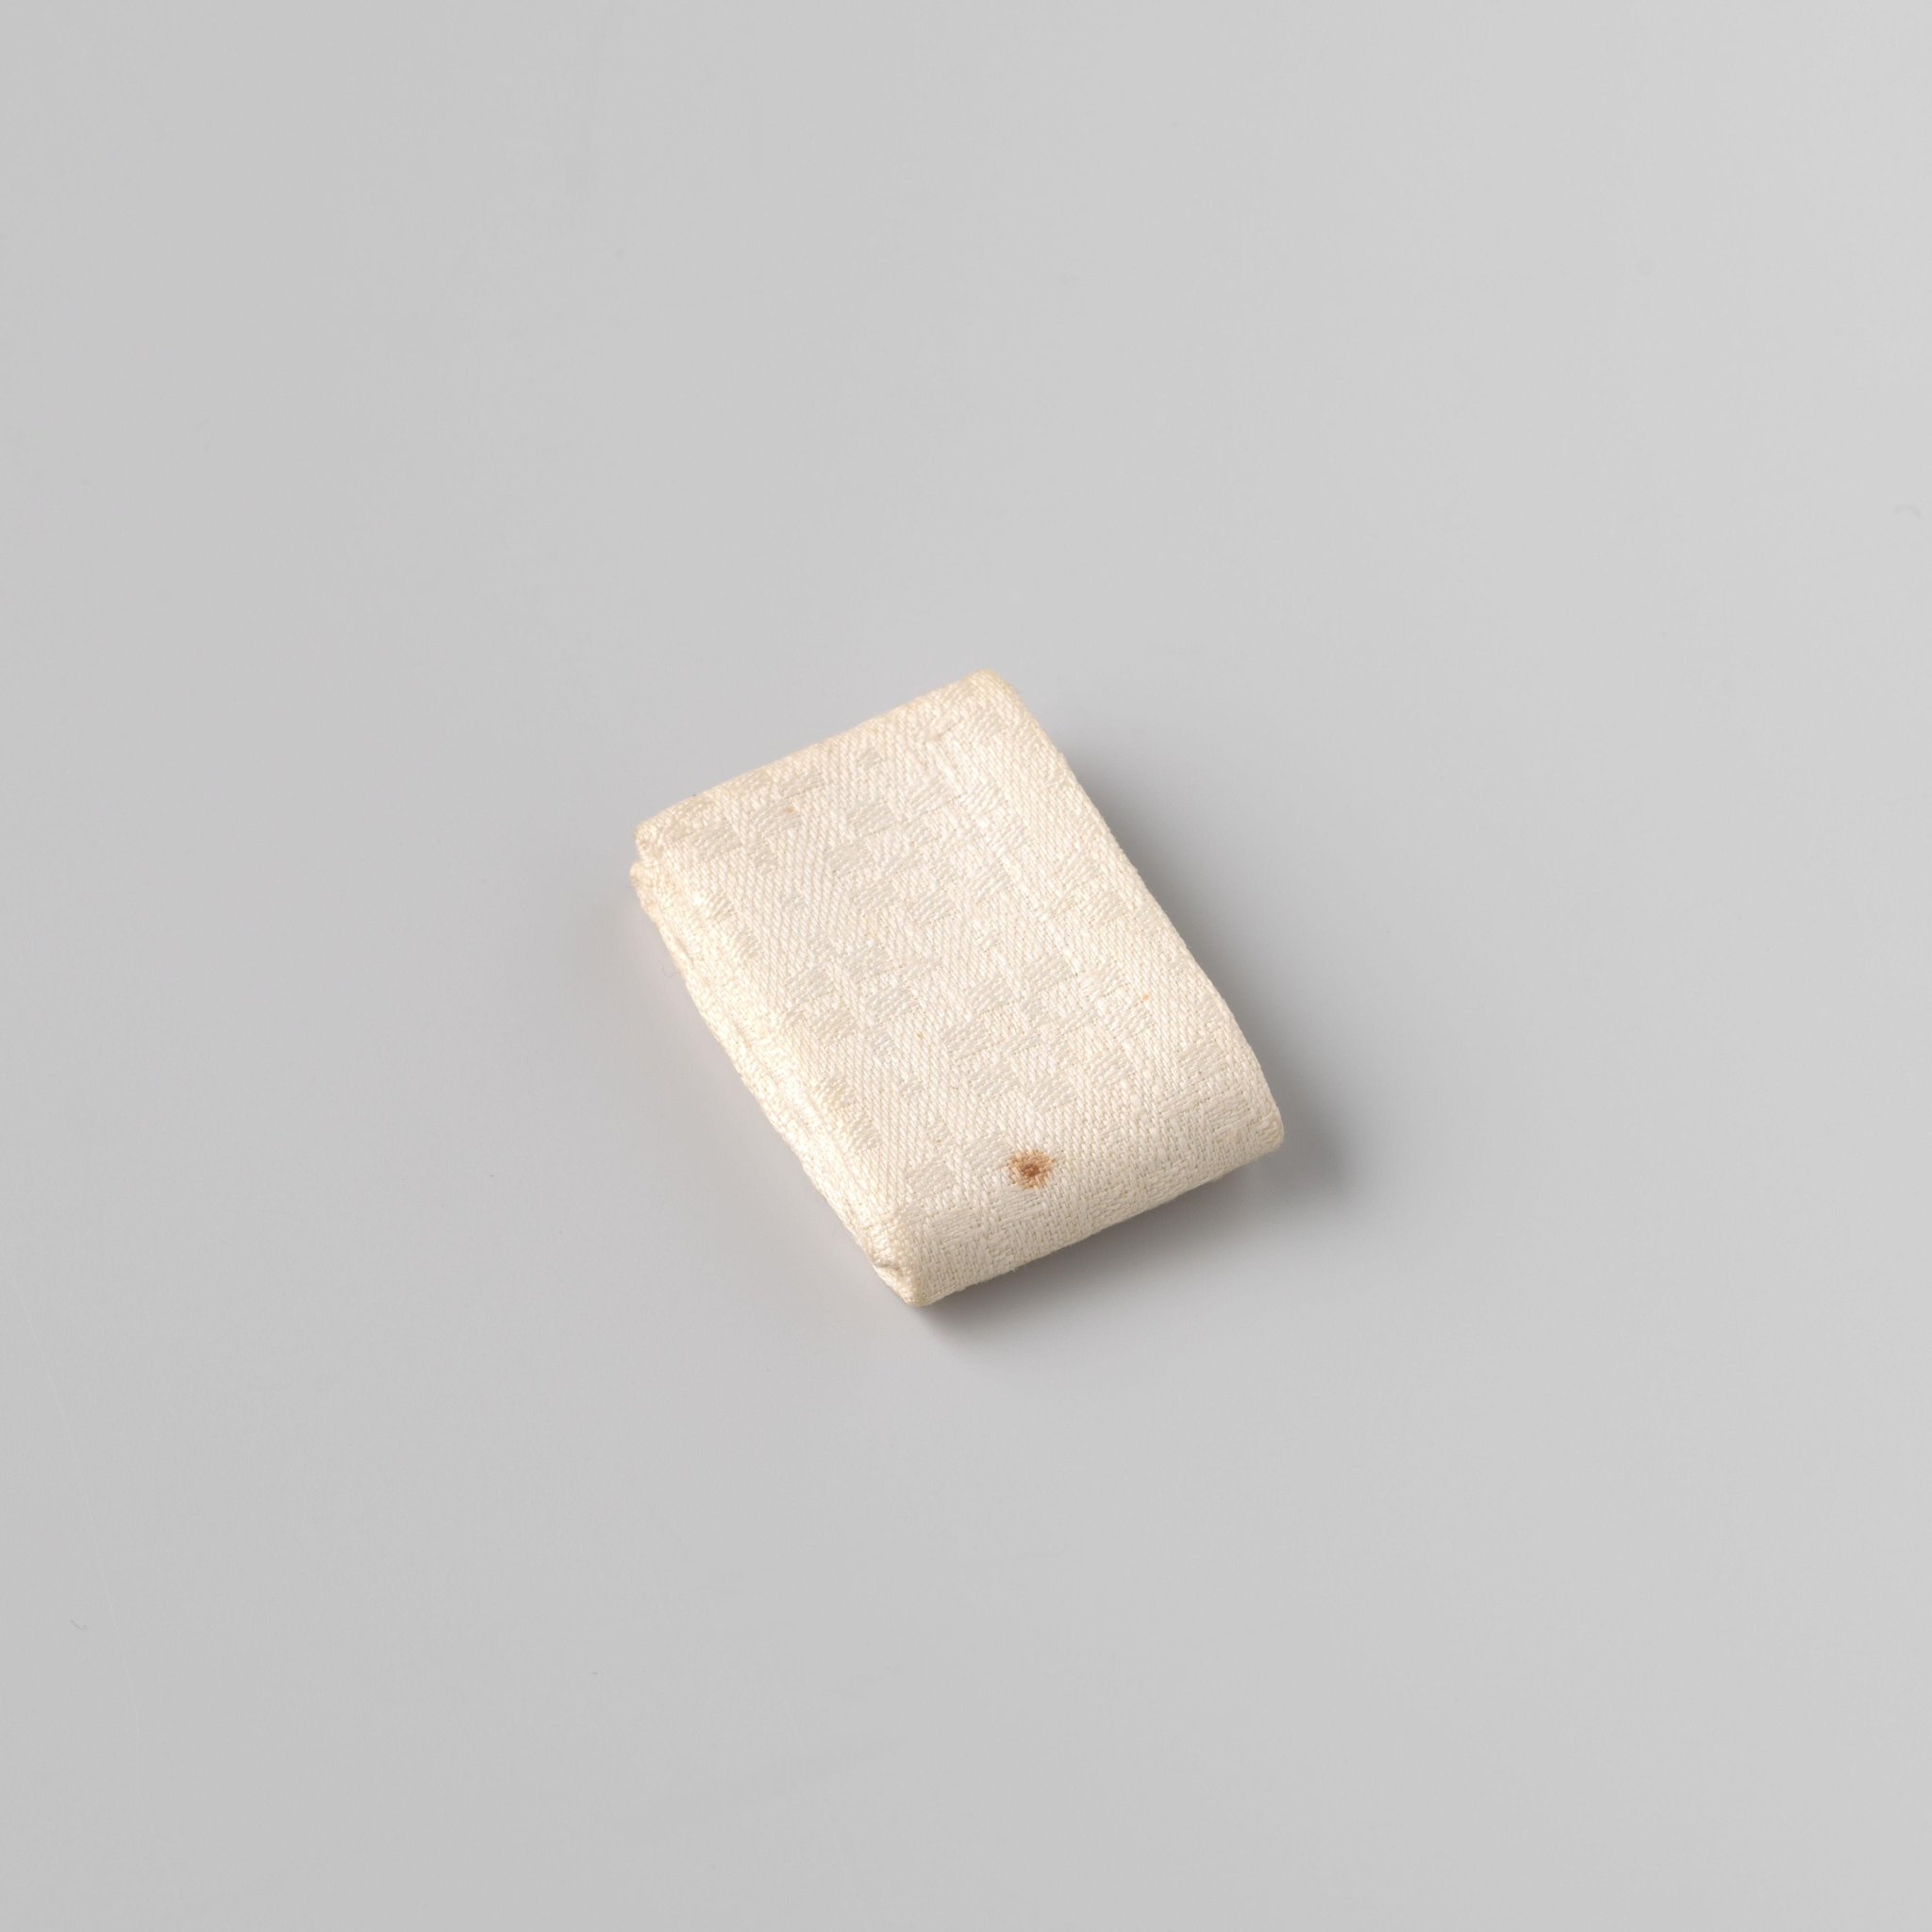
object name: dwaal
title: Linnen servet van damastweefsel met pellenpatroon (motief II), aan vier zijden omzoomd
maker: Anonymous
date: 1690-1710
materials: linen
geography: haarlem